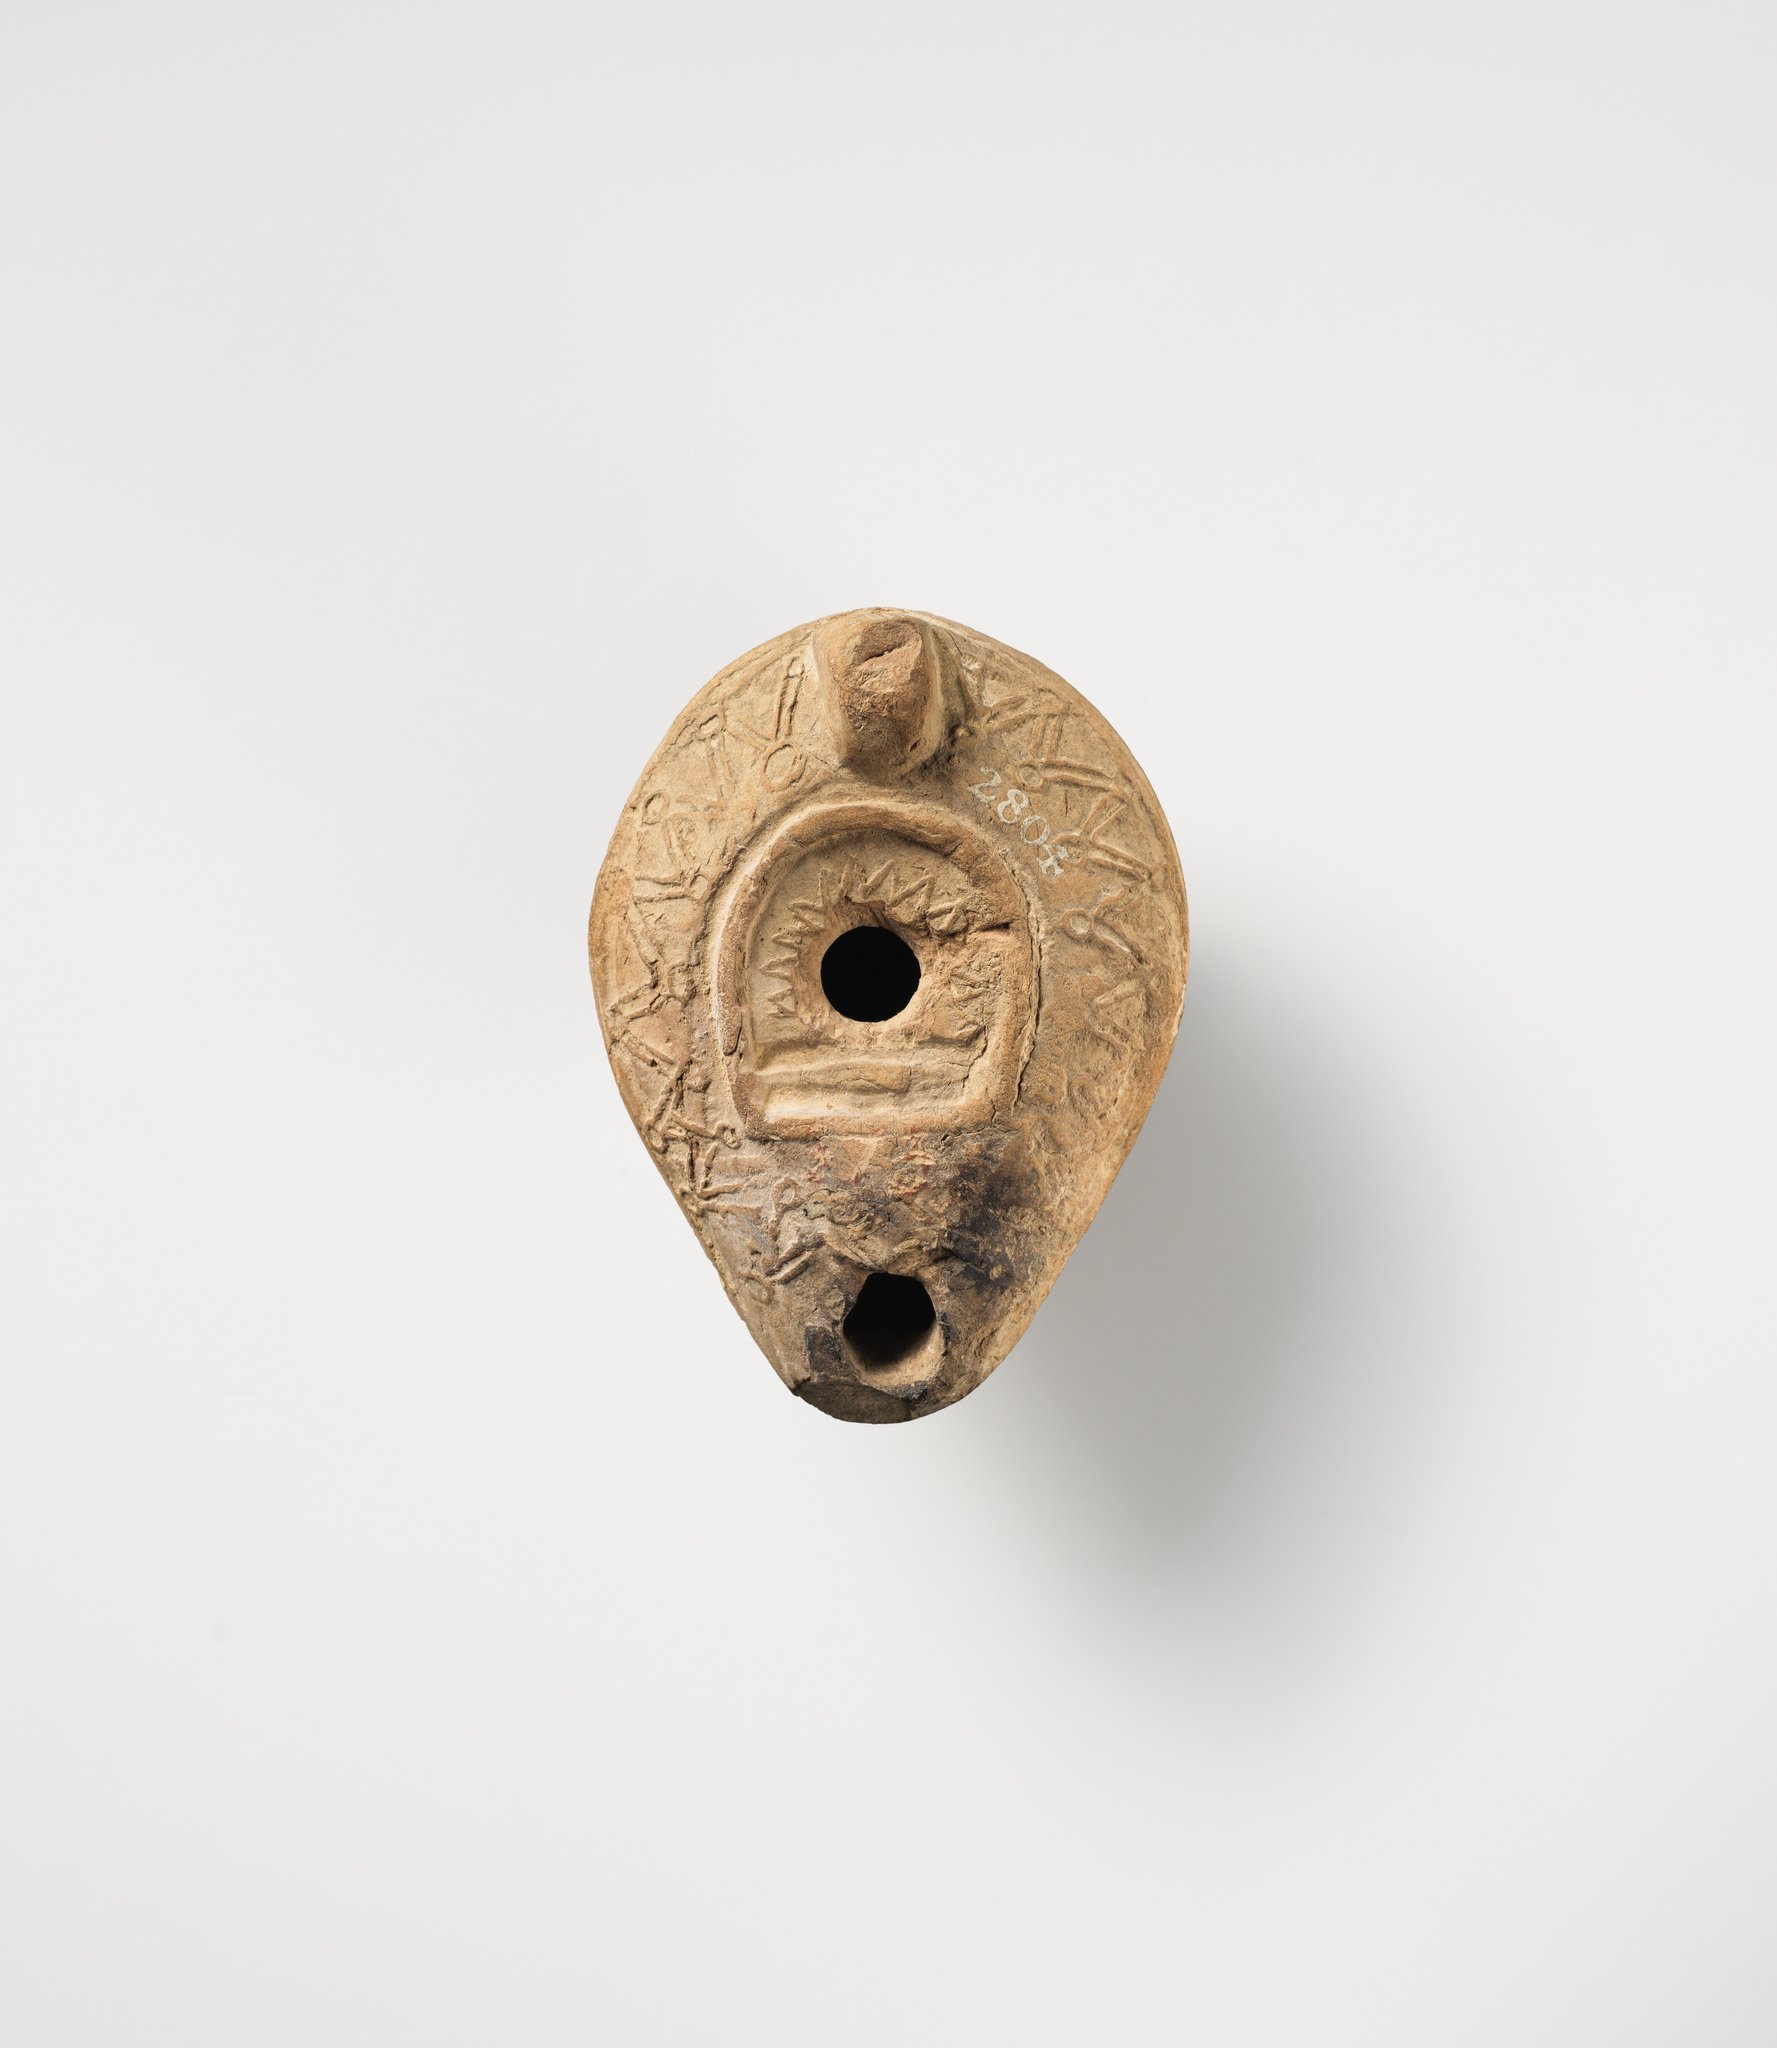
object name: lamp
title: Terracotta oil lamp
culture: roman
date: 201-300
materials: terracotta